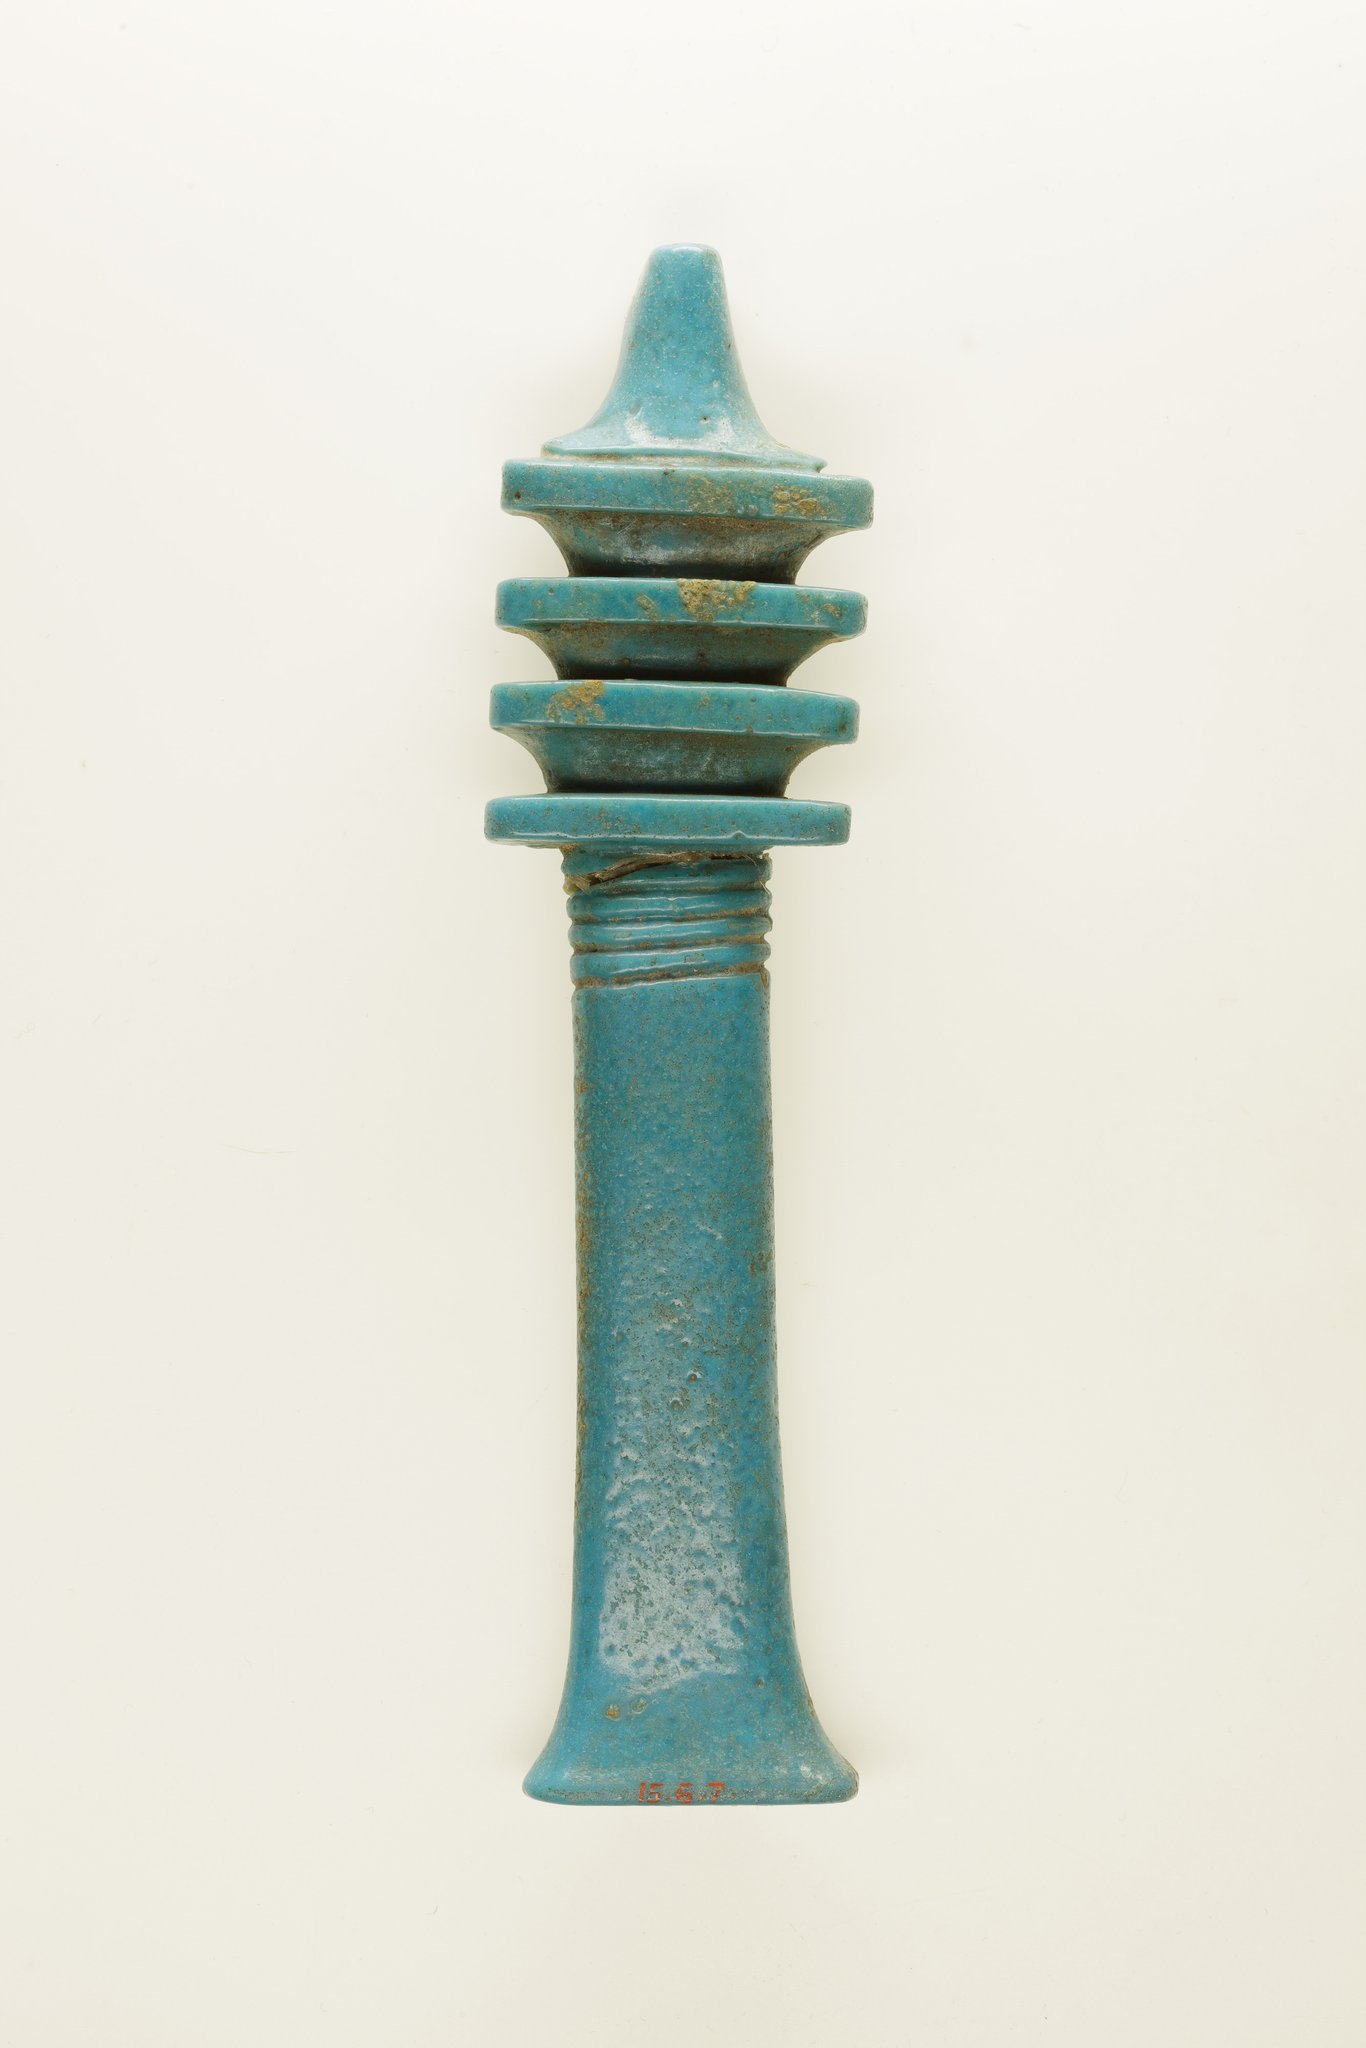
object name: amulet, djed pillar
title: Djed Pillar Amulet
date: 664-630 BCE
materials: faience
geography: egypt